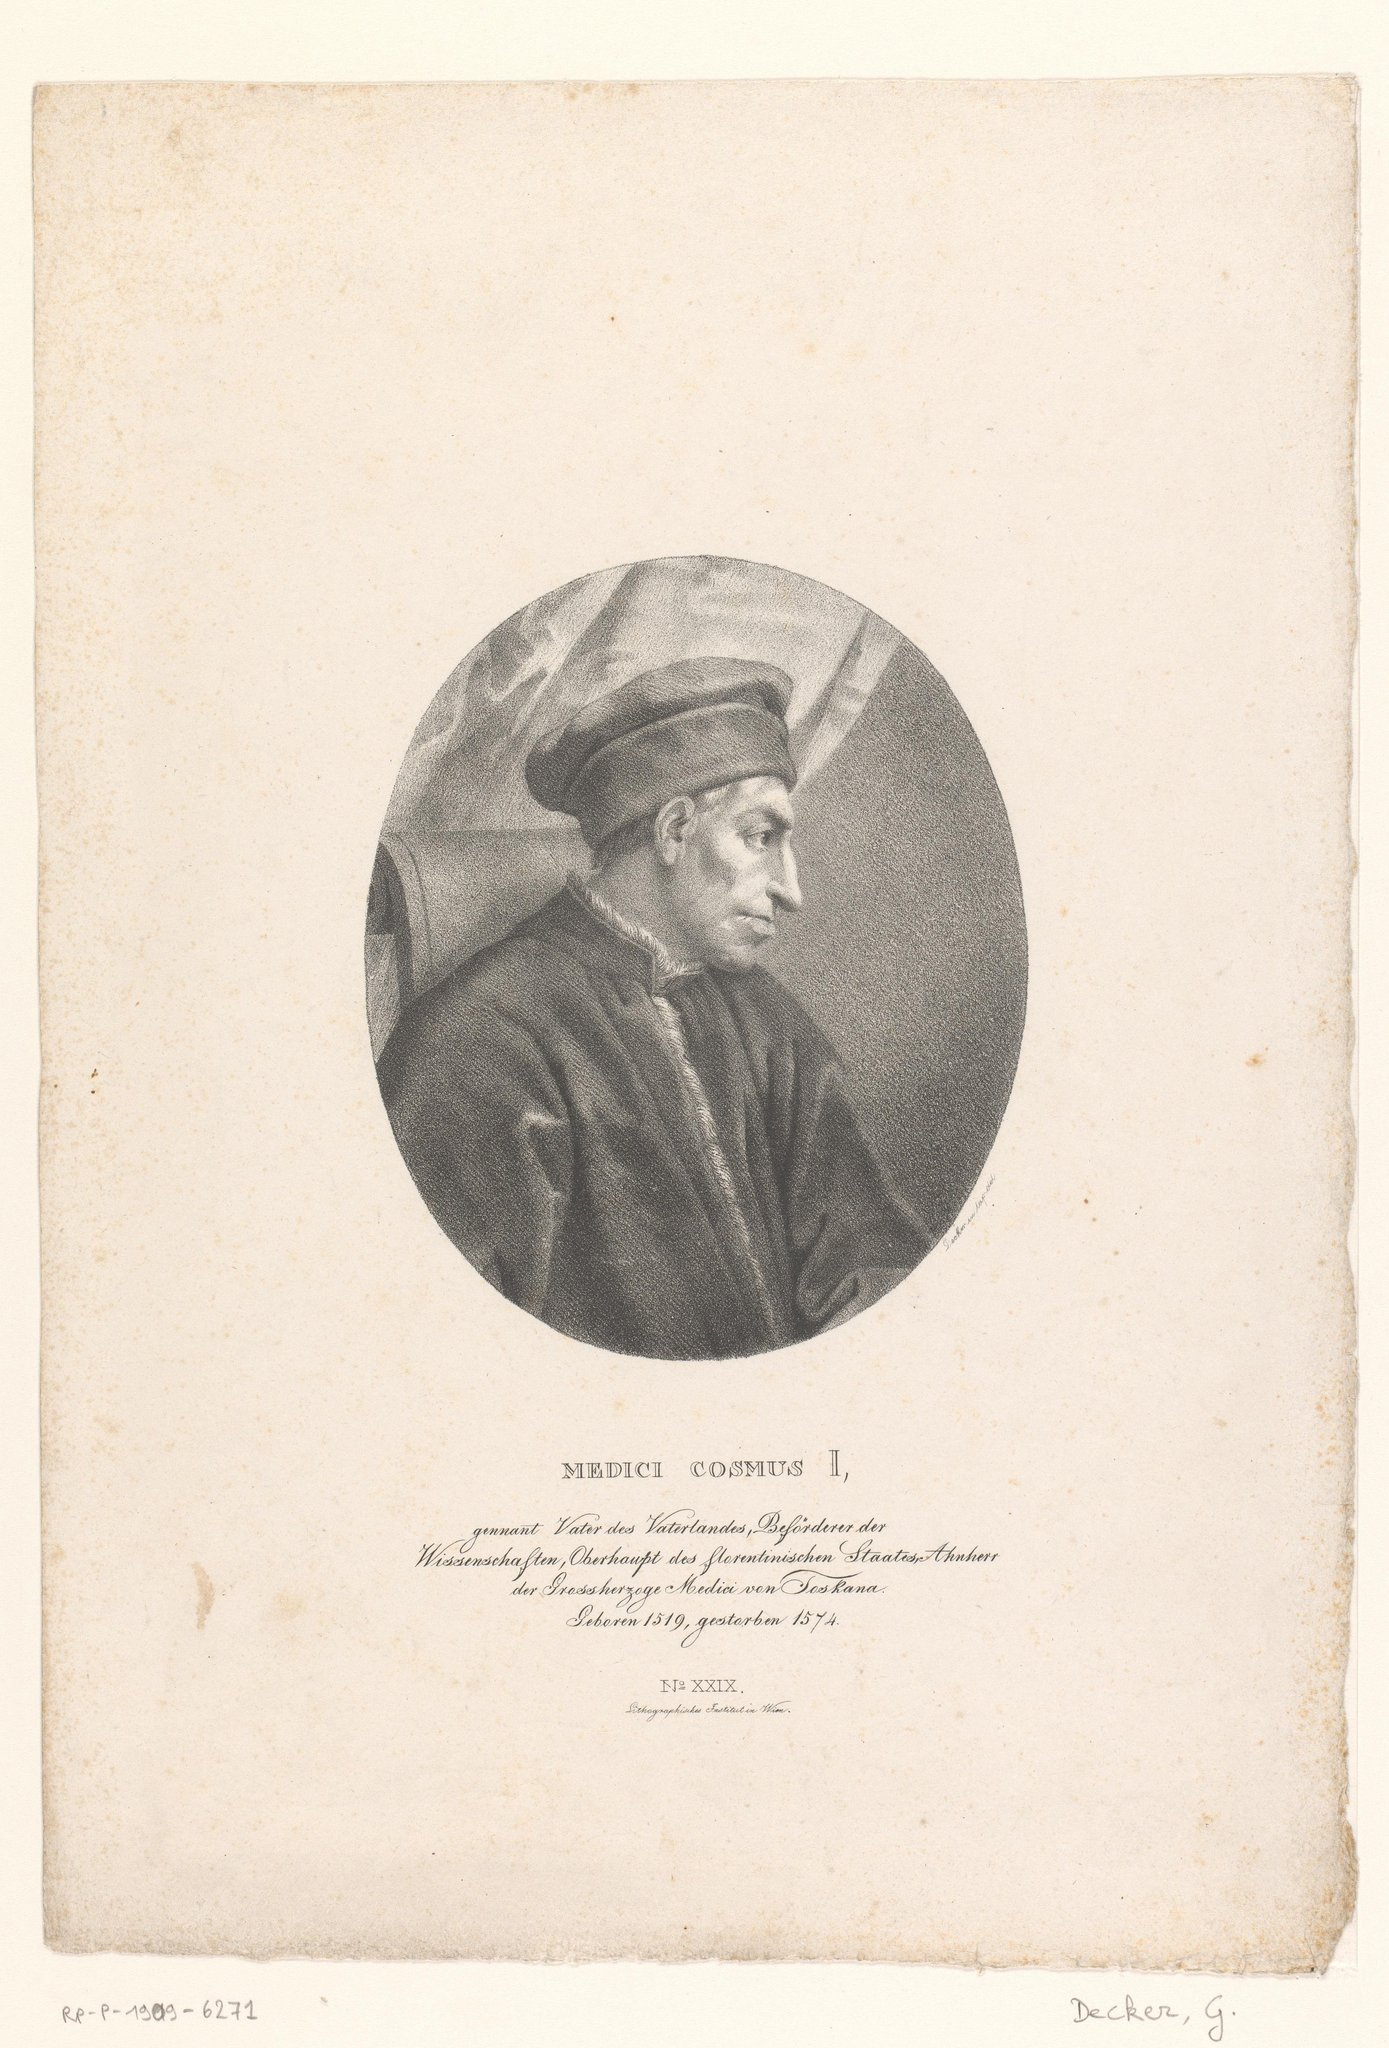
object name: print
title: Medici Cosmus I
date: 1831-1855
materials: paper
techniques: lithograph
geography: vienna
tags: cosimo i de' medici, head-gear, adult man, historical persons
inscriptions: collector's mark: Lugt 2228